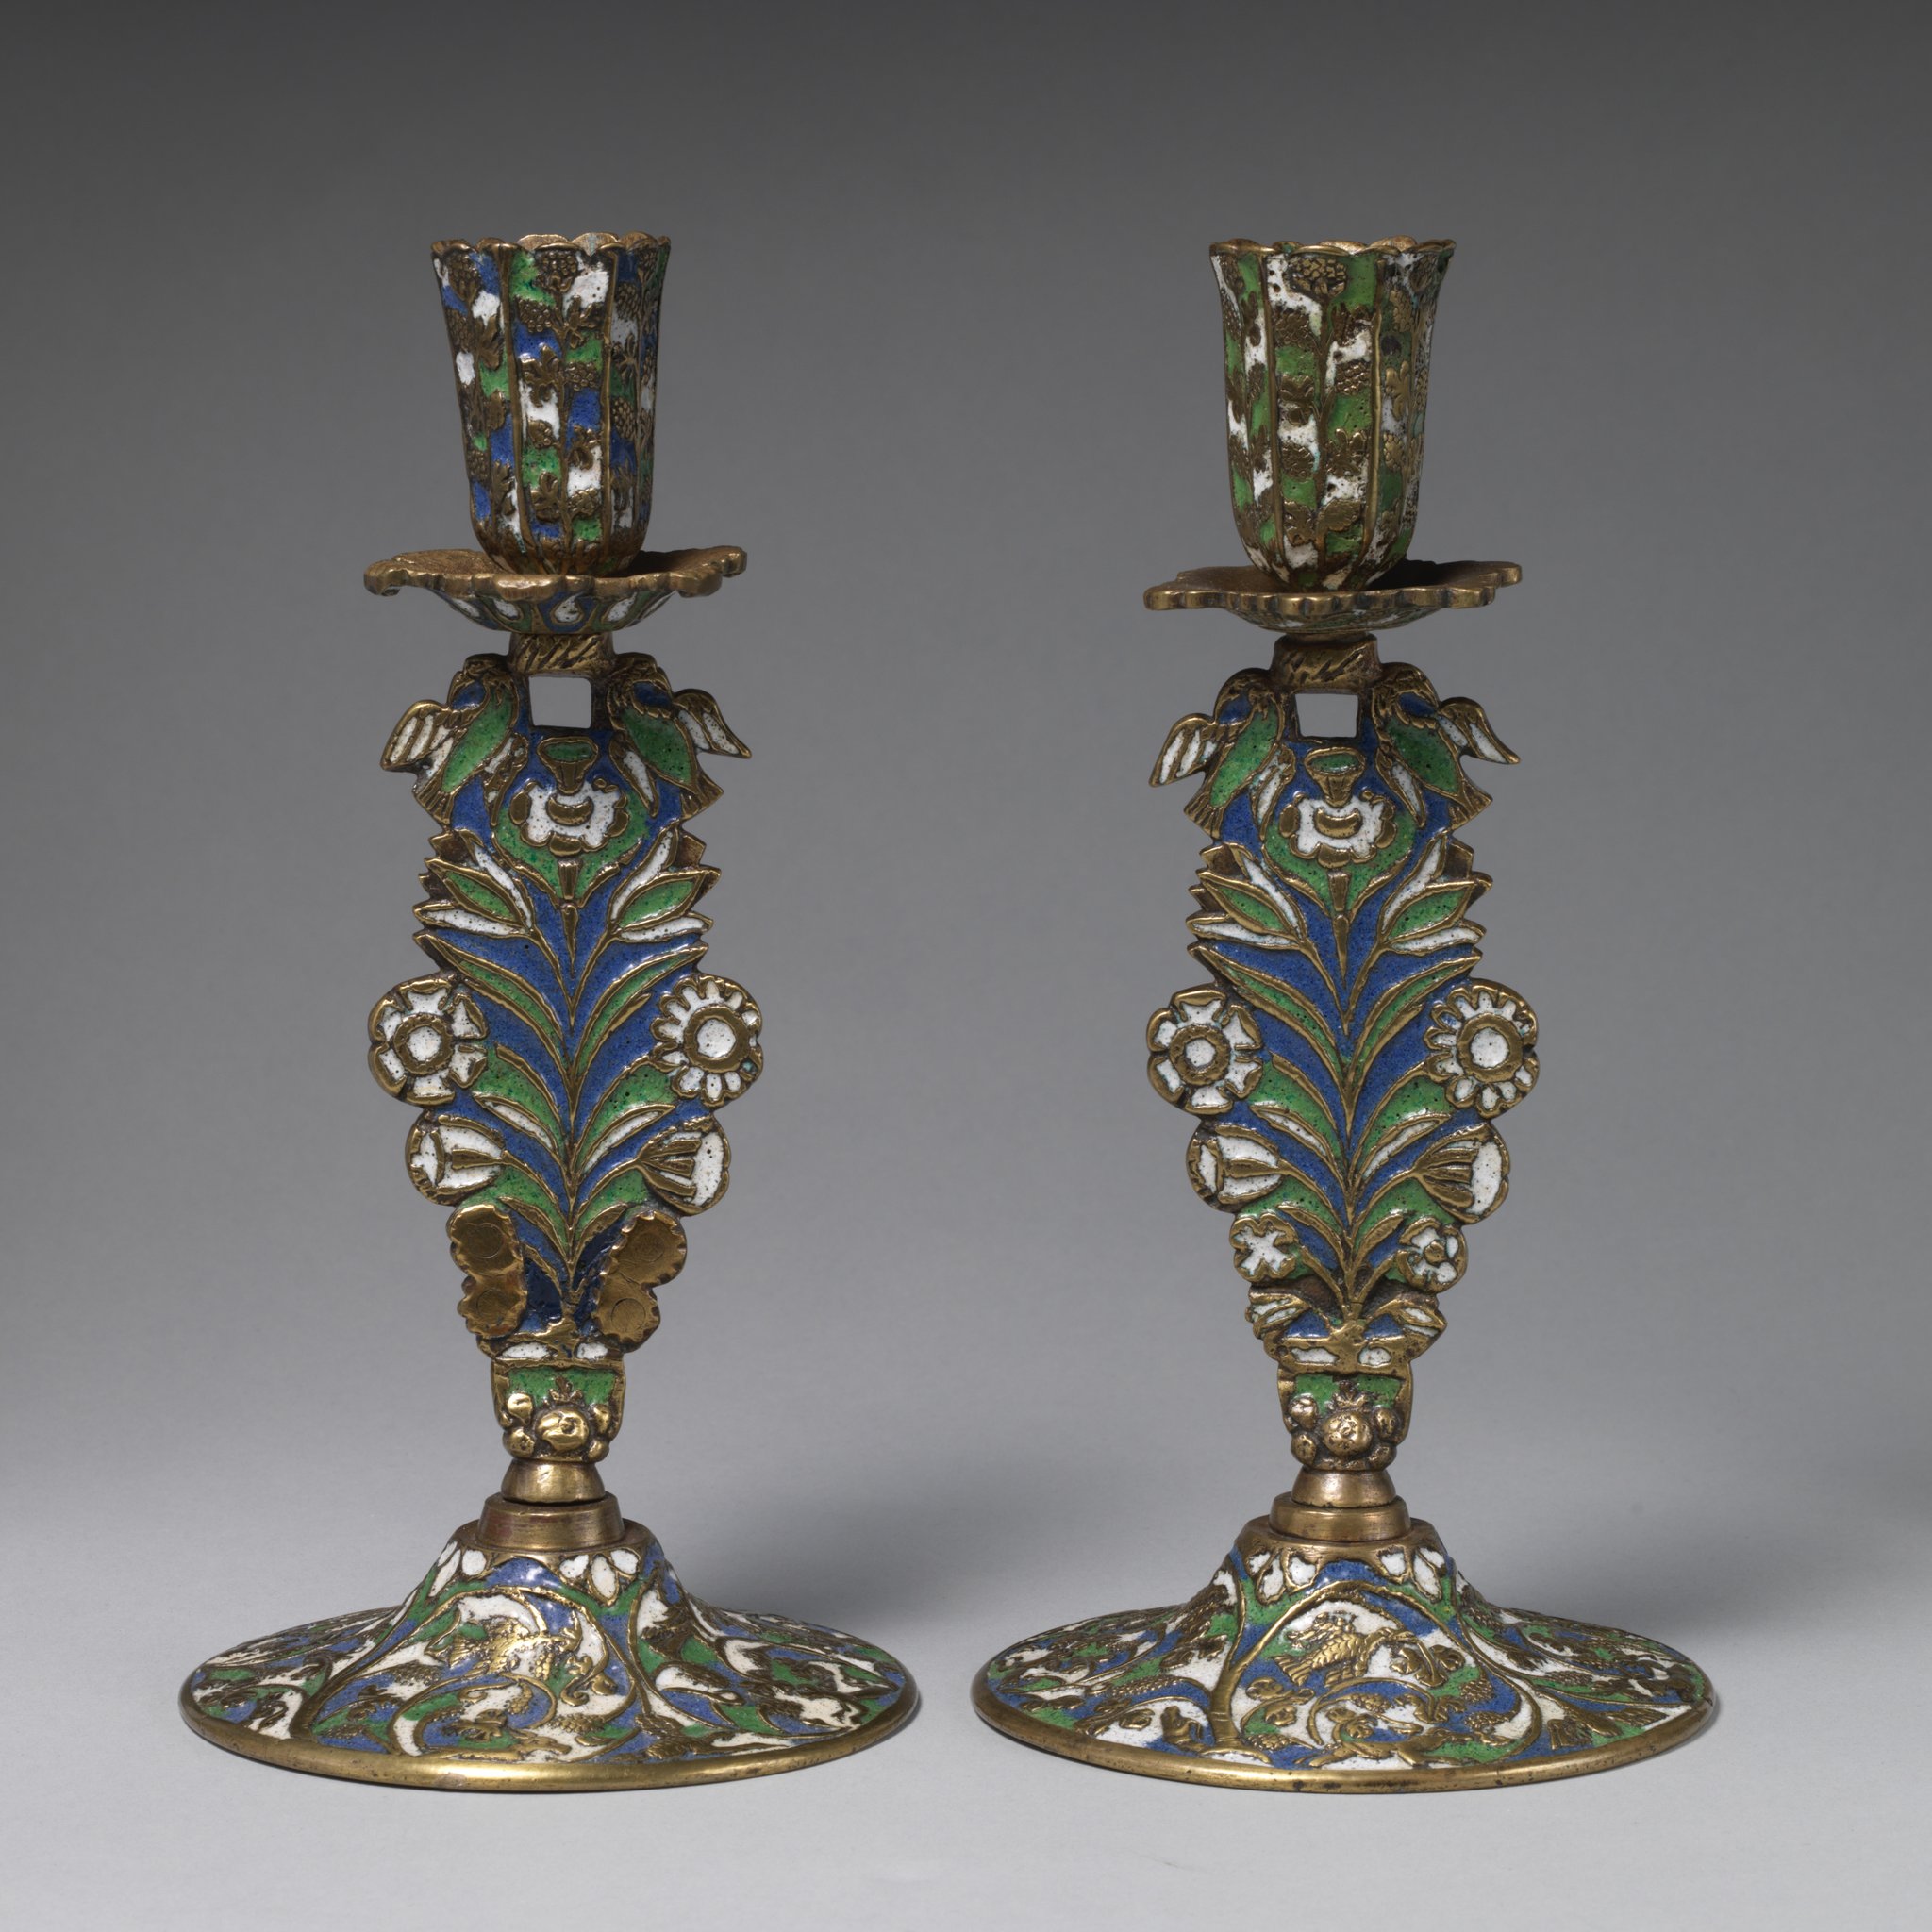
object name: candlestick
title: Candlestick (one of a pair)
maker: stephen pilcherd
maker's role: maker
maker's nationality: british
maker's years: 1570-1670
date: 1660-1680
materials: brass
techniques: enamel